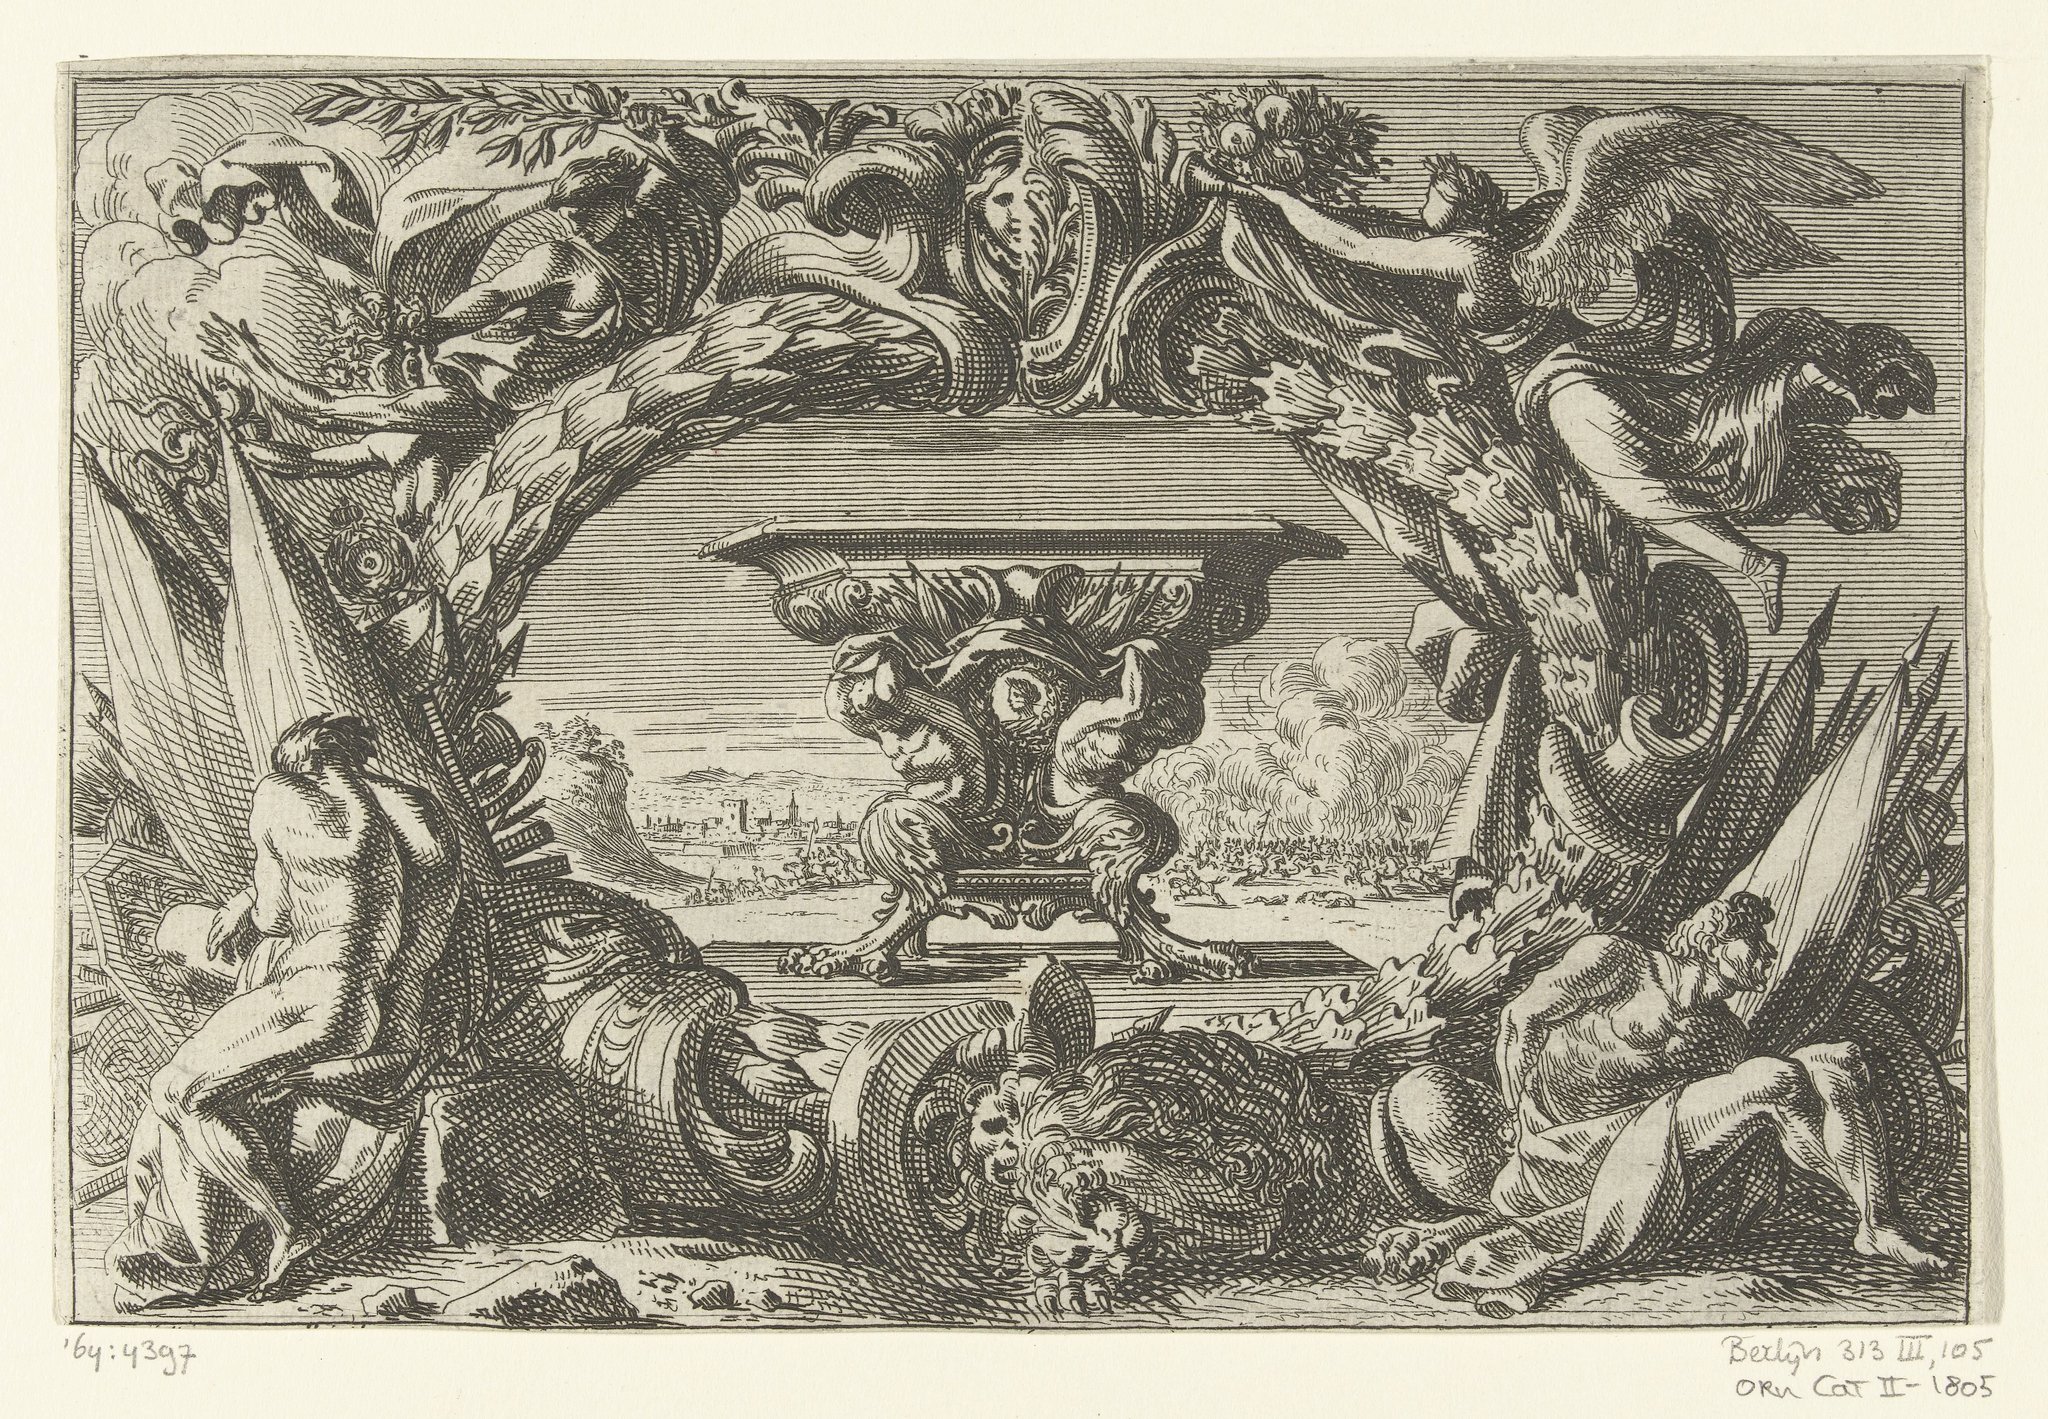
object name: print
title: Zoutvat in cartouche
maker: jean lepautre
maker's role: draughtsman, print maker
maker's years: 1618-1682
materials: paper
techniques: etching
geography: france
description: Het zoutvat wordt ondersteund door twee mannelijke bovenlichamen die ontspruiten uit bladranken. Uit serie van 6 bladen.